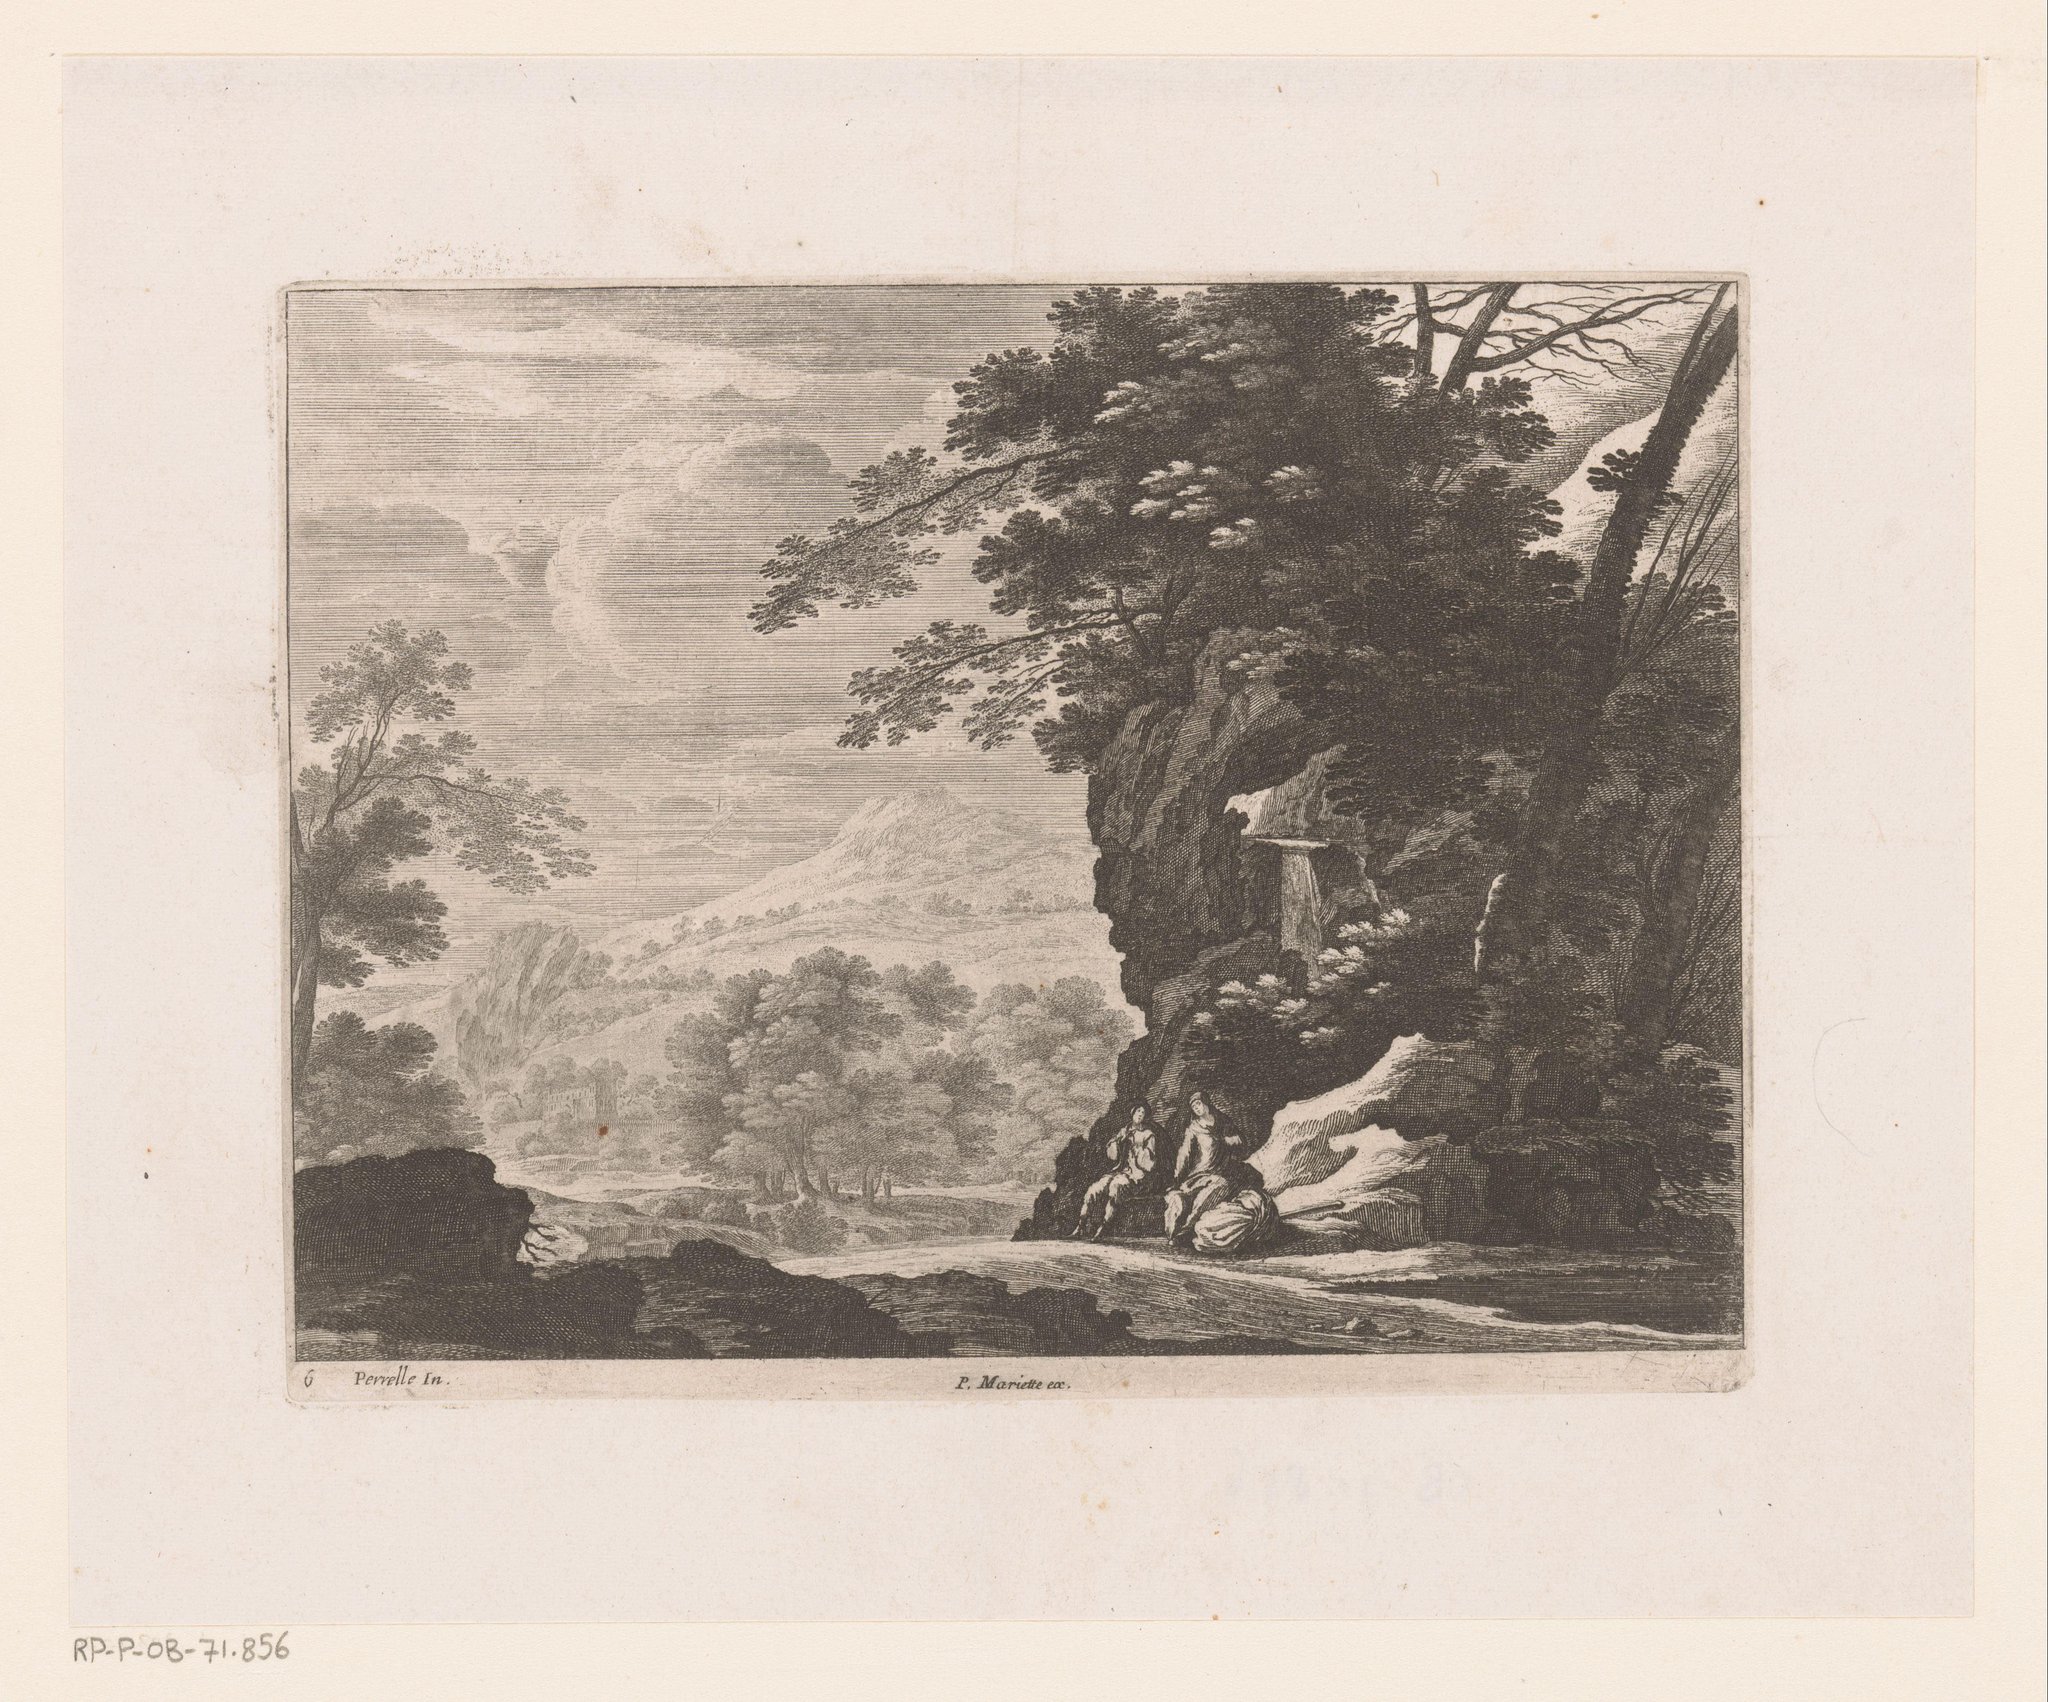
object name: print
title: Heuvelachtig landschap met rustende reizigers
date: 1613-1695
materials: paper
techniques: engraving, etching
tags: 'en route', traveller under way, mountains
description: Prenten met het signatuur 'Perelle' kunnen zowel door vader Gabriel als door zonen Nicolas en Adam gemaakt zijn.